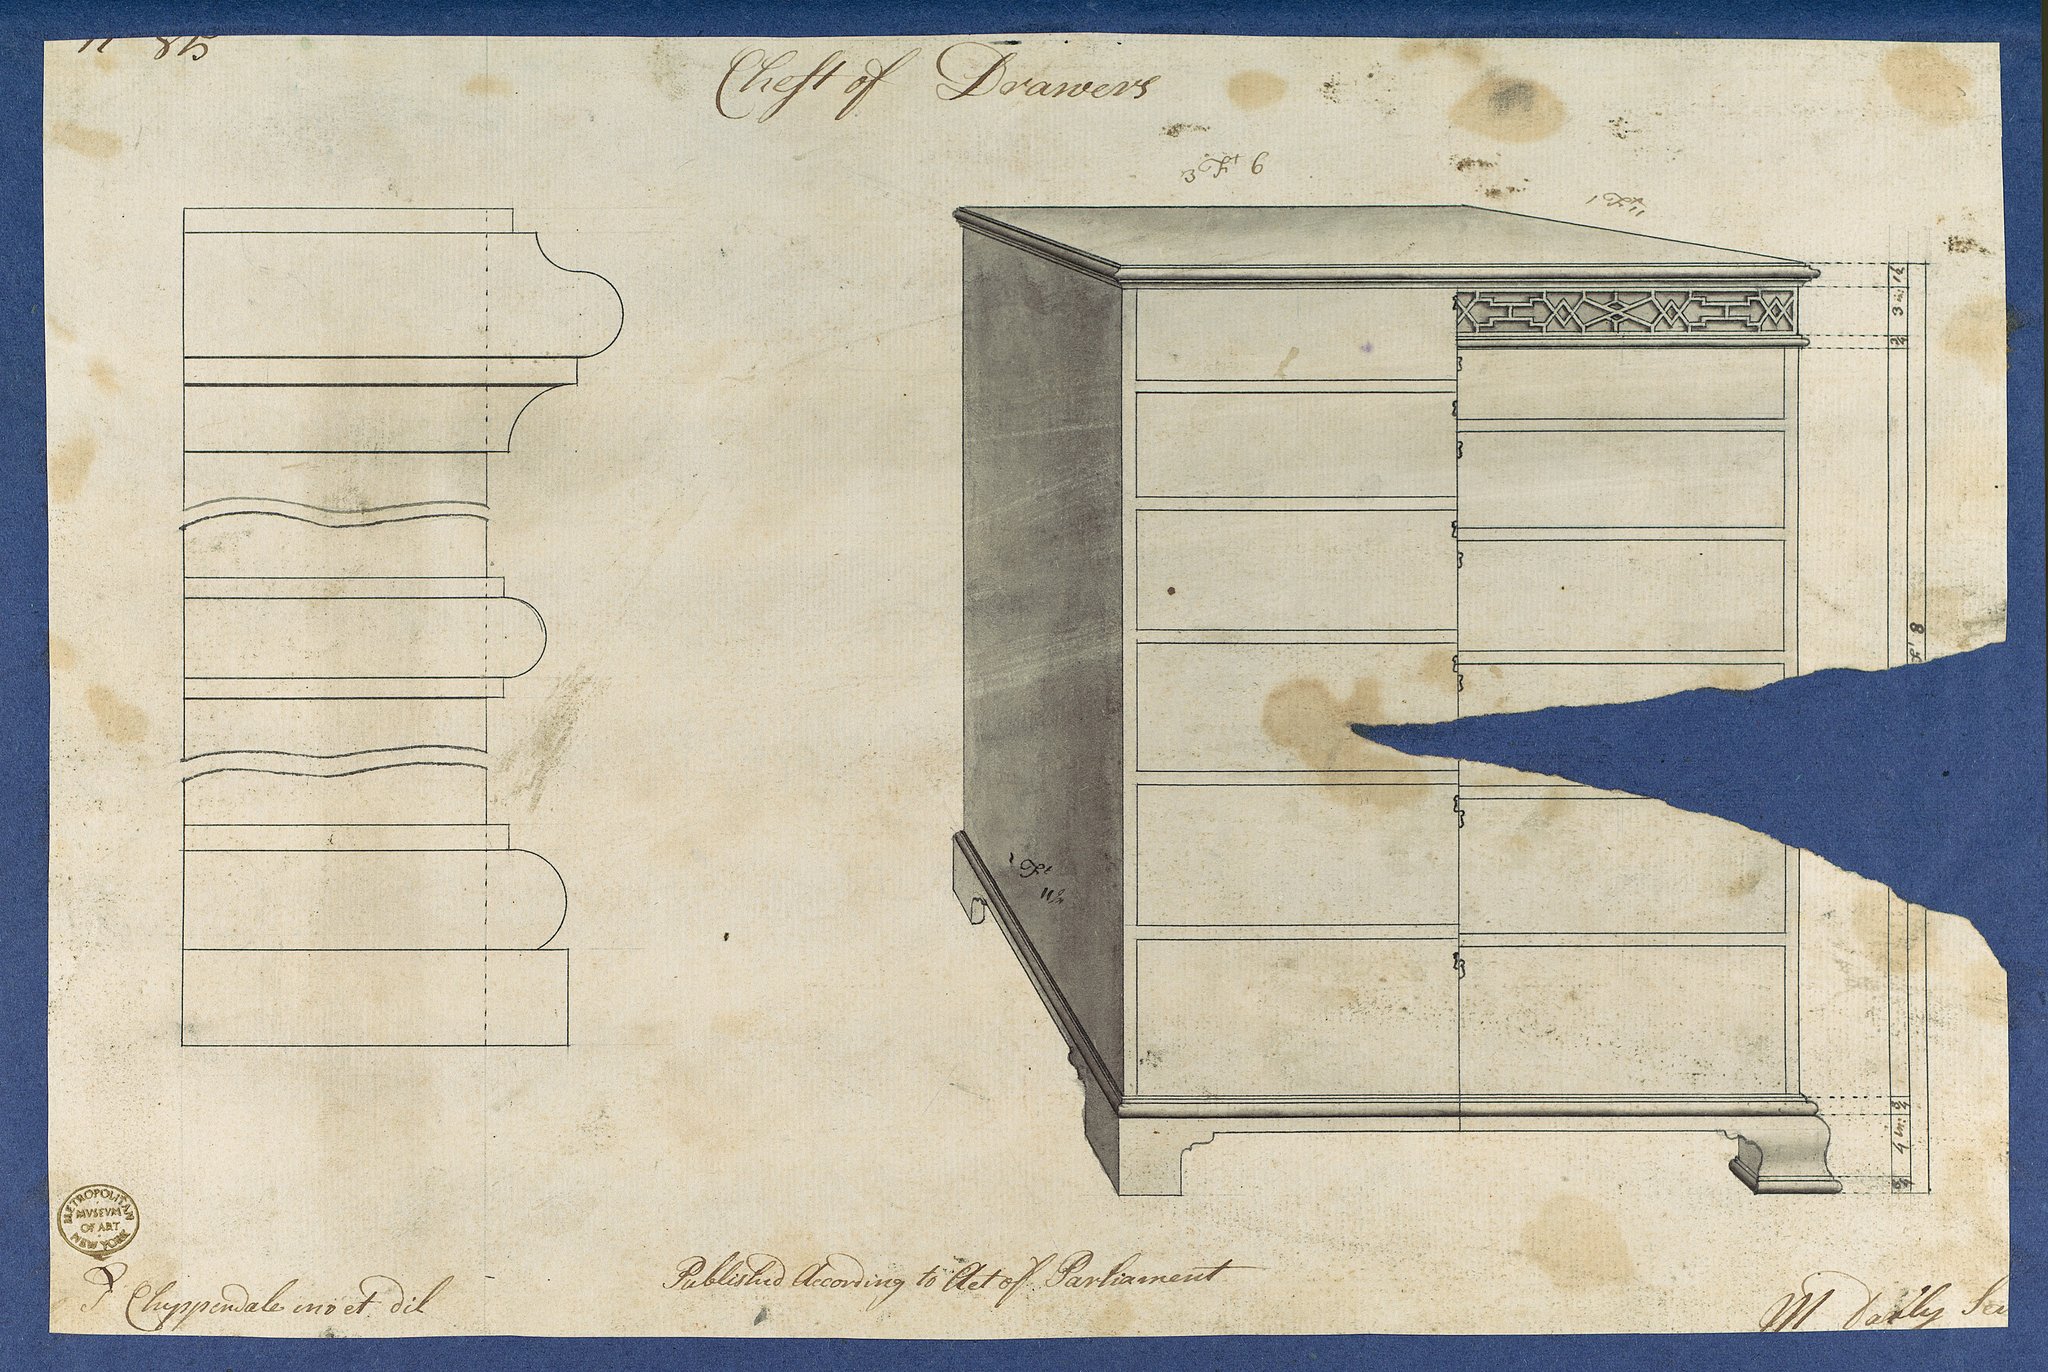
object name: drawing ornament architecture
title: Chest of Drawers, from Chippendale Drawings, Vol. II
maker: thomas chippendale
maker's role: artist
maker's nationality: british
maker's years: 1718-1779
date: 1753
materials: ink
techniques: wash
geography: london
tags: chests